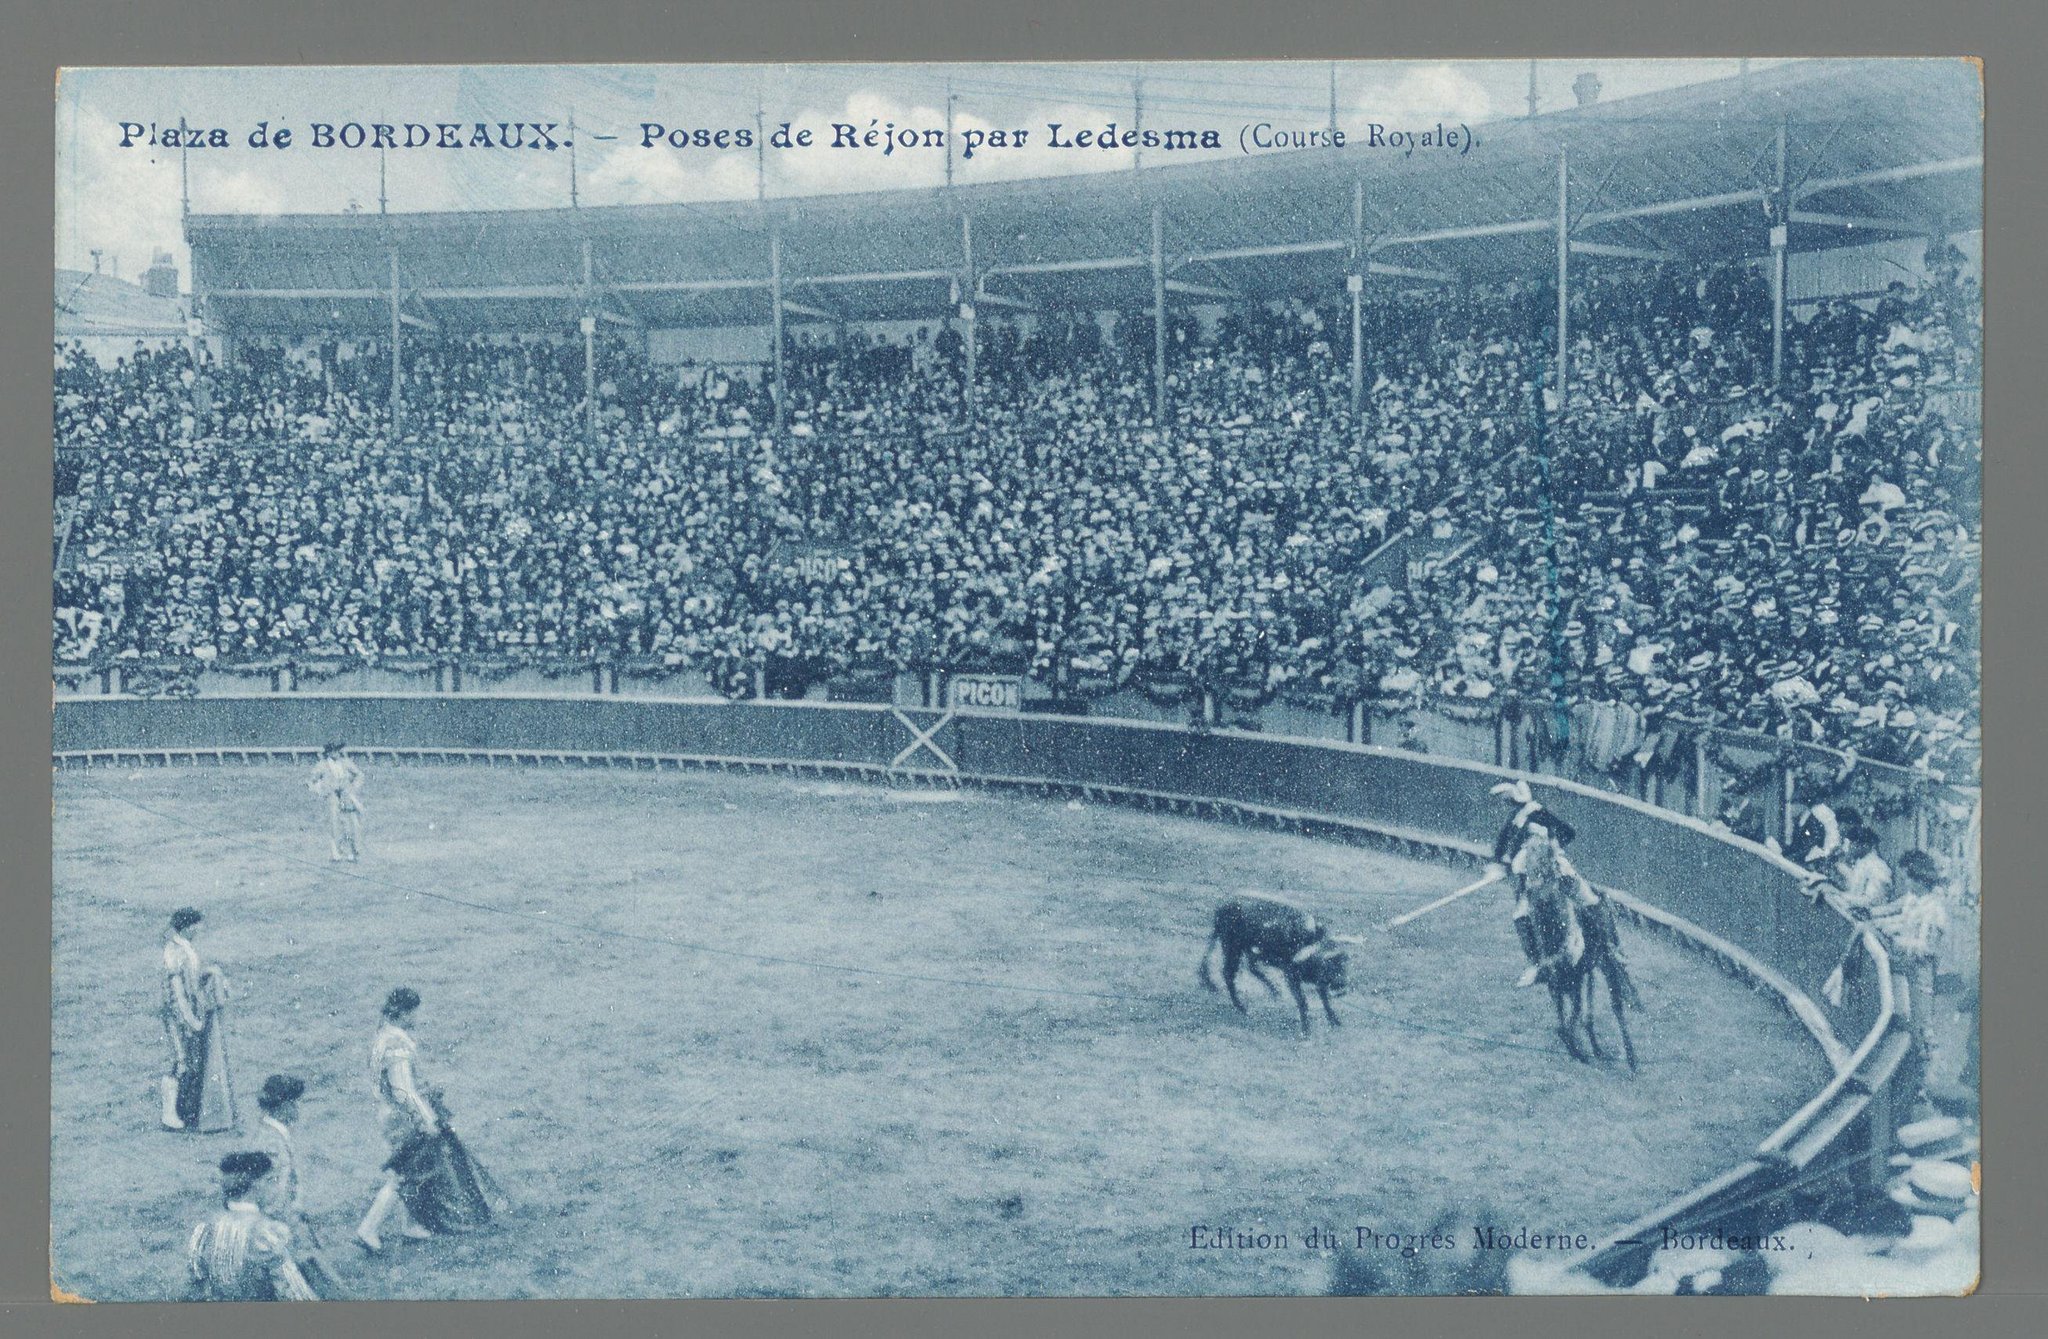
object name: ansichtkaart, prentbriefkaart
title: Plaza de Bordeaux. Poses de Réjon par Ledesma (Course Royale)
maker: Anonymous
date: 1904-1906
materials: cardboard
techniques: photograph, writing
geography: bordeaux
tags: theatre, theatrical performance, bullfight, the audience ~ art performance